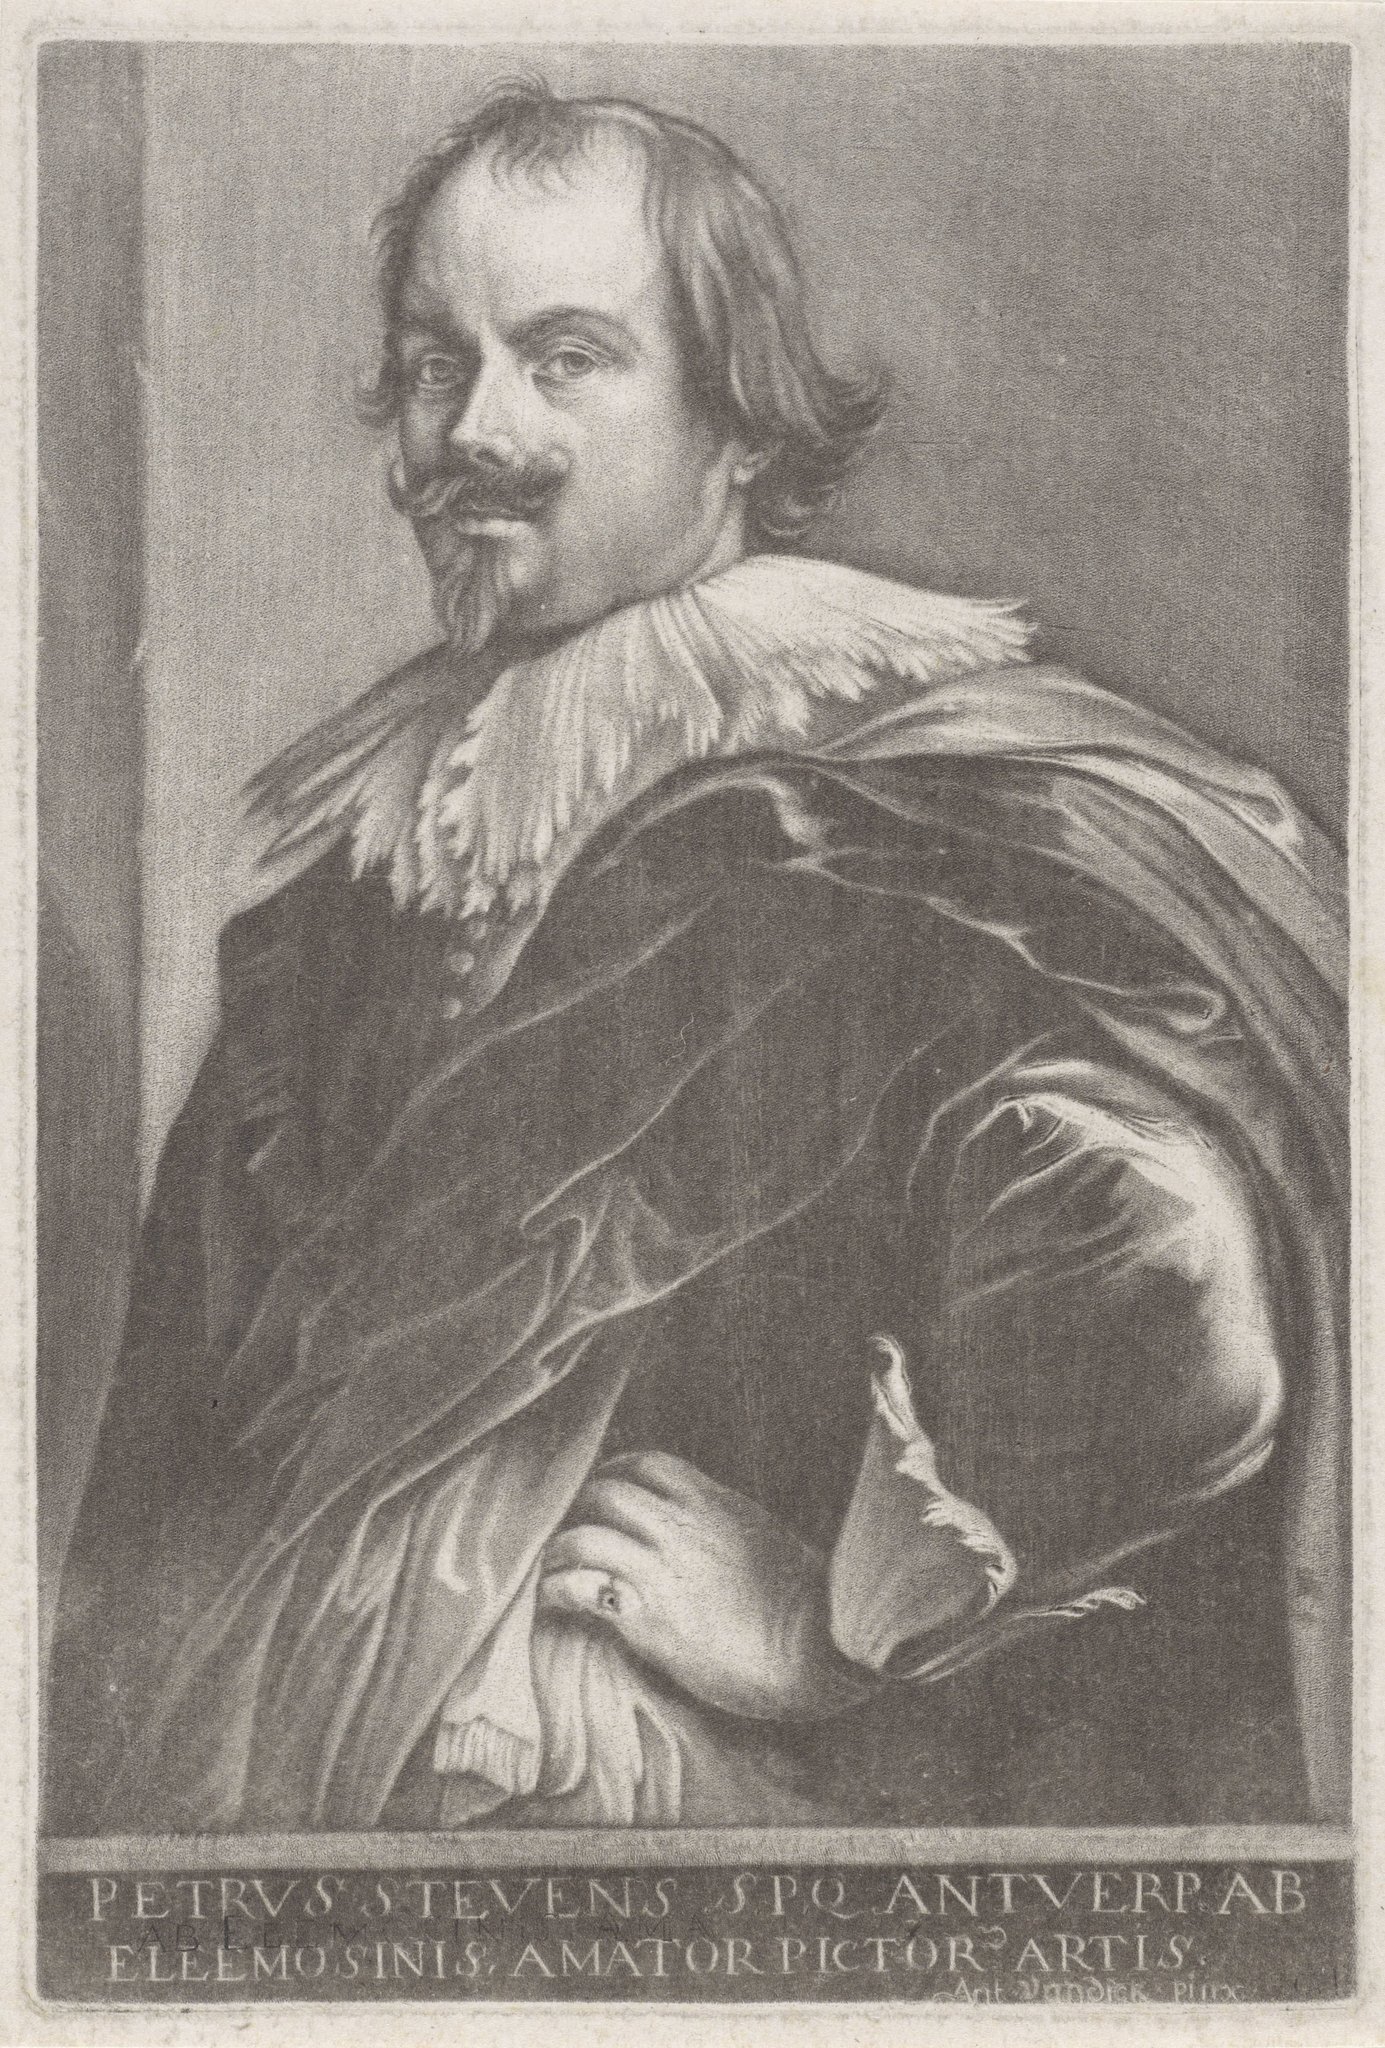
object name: print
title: Portret van Peeter Stevens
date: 1650-1800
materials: paper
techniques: mezzotint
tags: antwerp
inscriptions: collector's mark: Lugt 2228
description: Peeter Stevens, handelaar en kunstverzamelaar te Antwerpen.